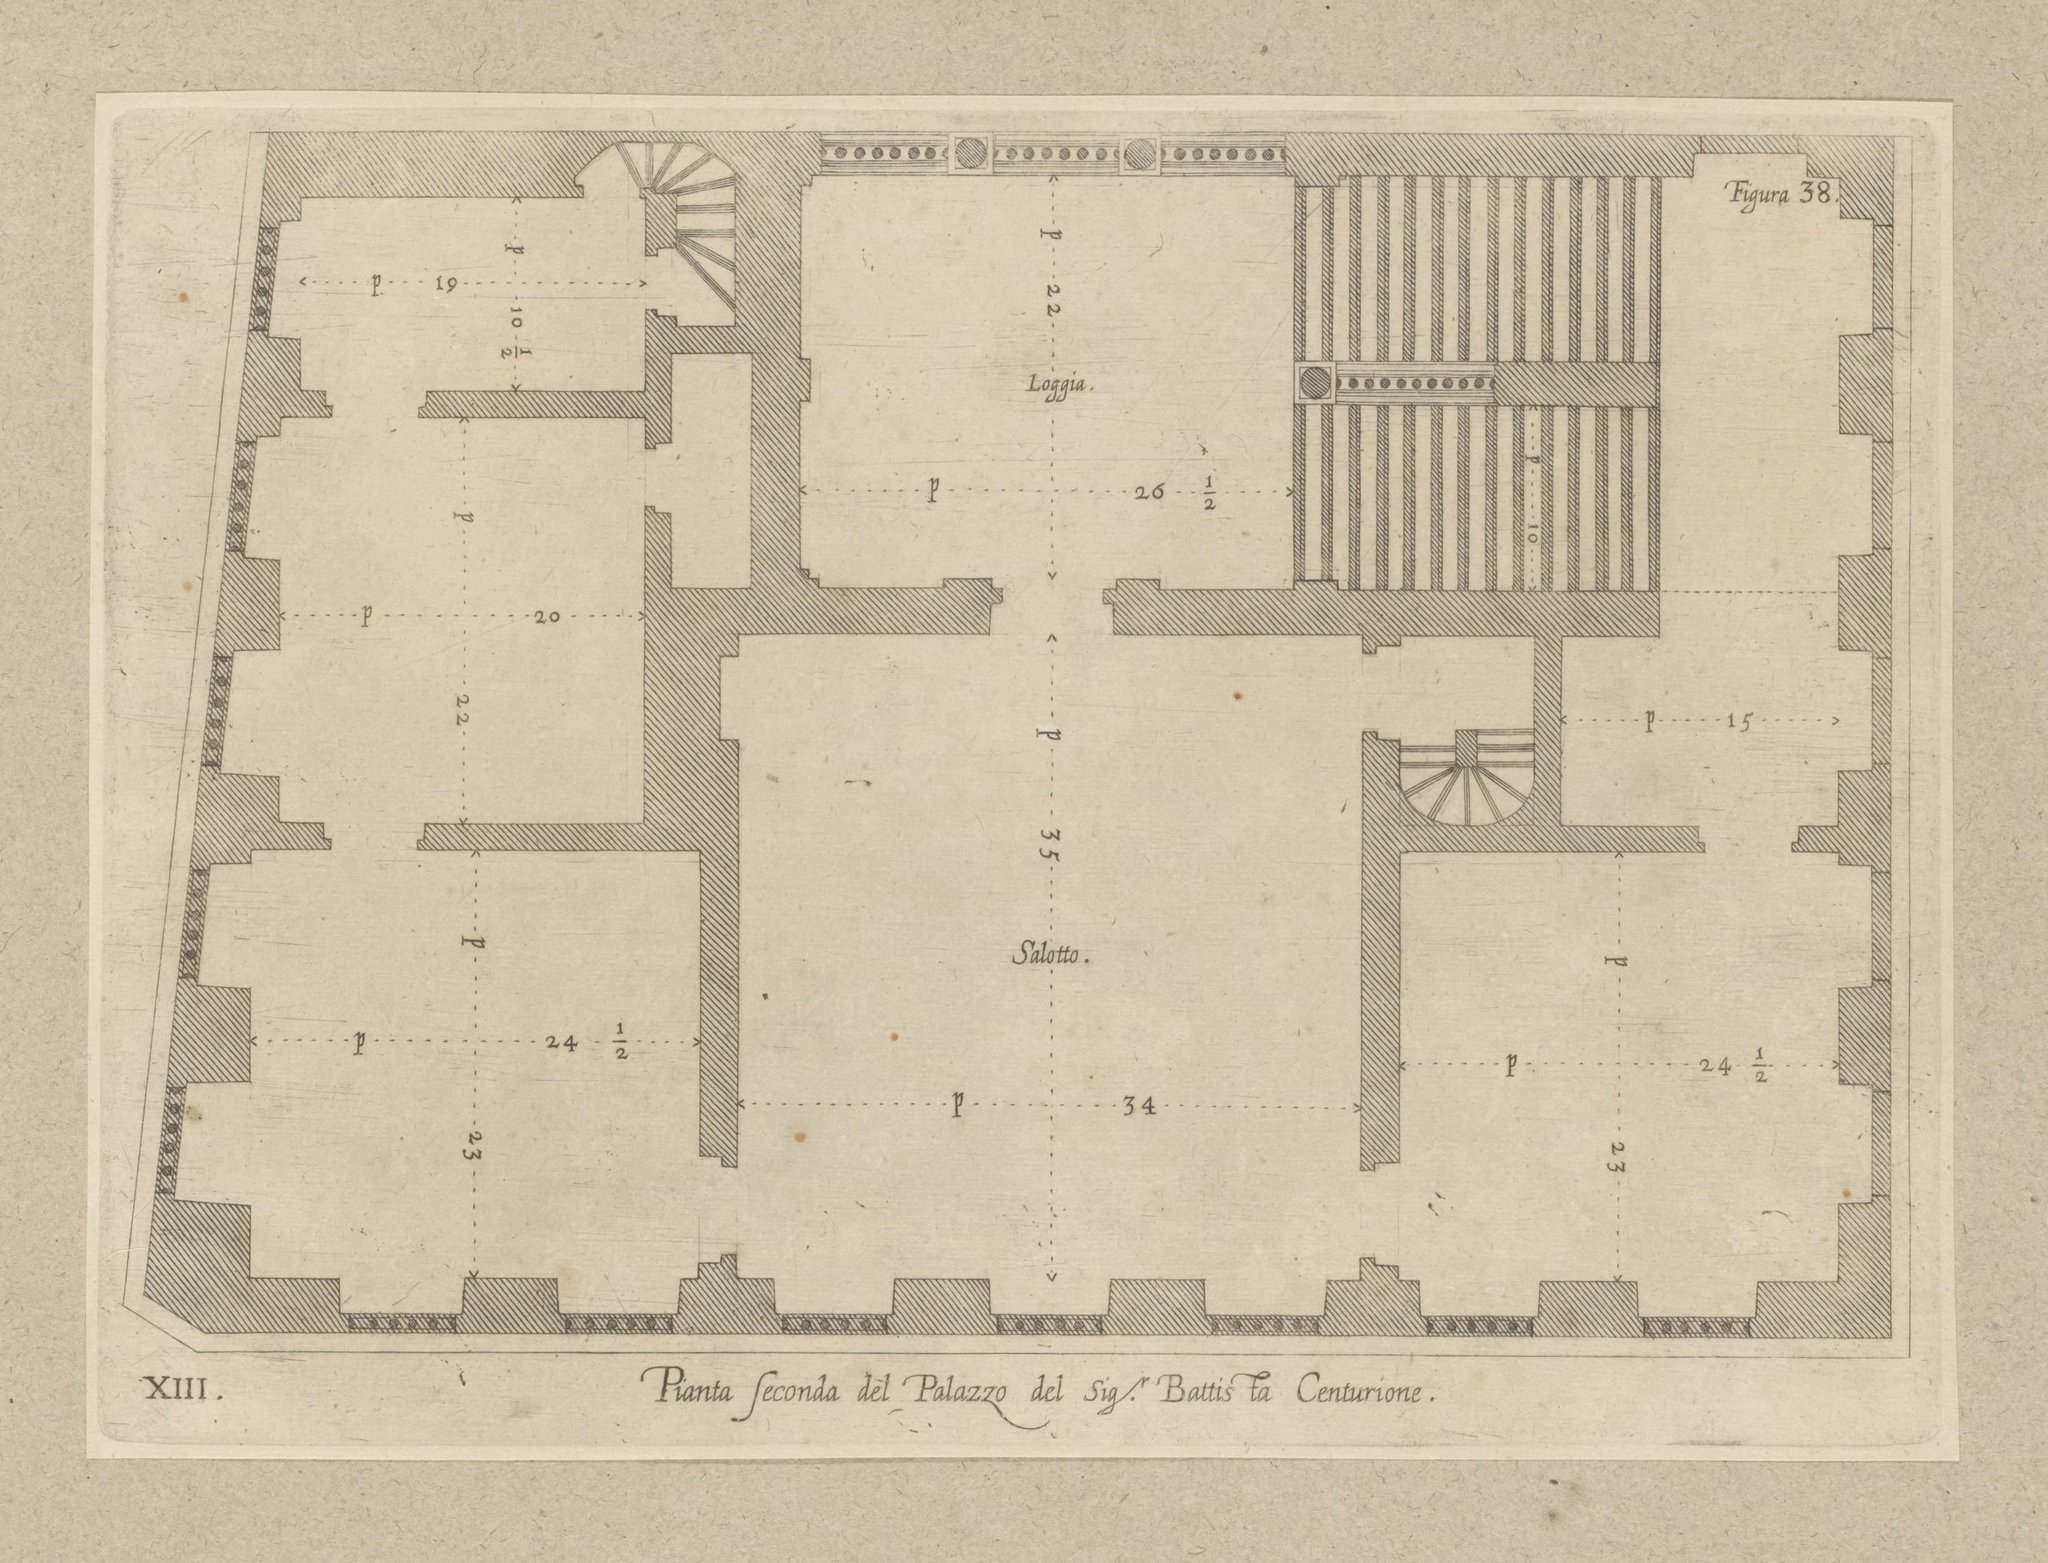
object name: print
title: Prima seconda del Palazzo del Sigr. Battista Centurione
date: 1622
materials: paper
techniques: engraving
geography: antwerp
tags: hôtel, i.e. small palace in city - aa - civic architecture: inside, plan ~ architecture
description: Deze prent maakt deel uit van een album.